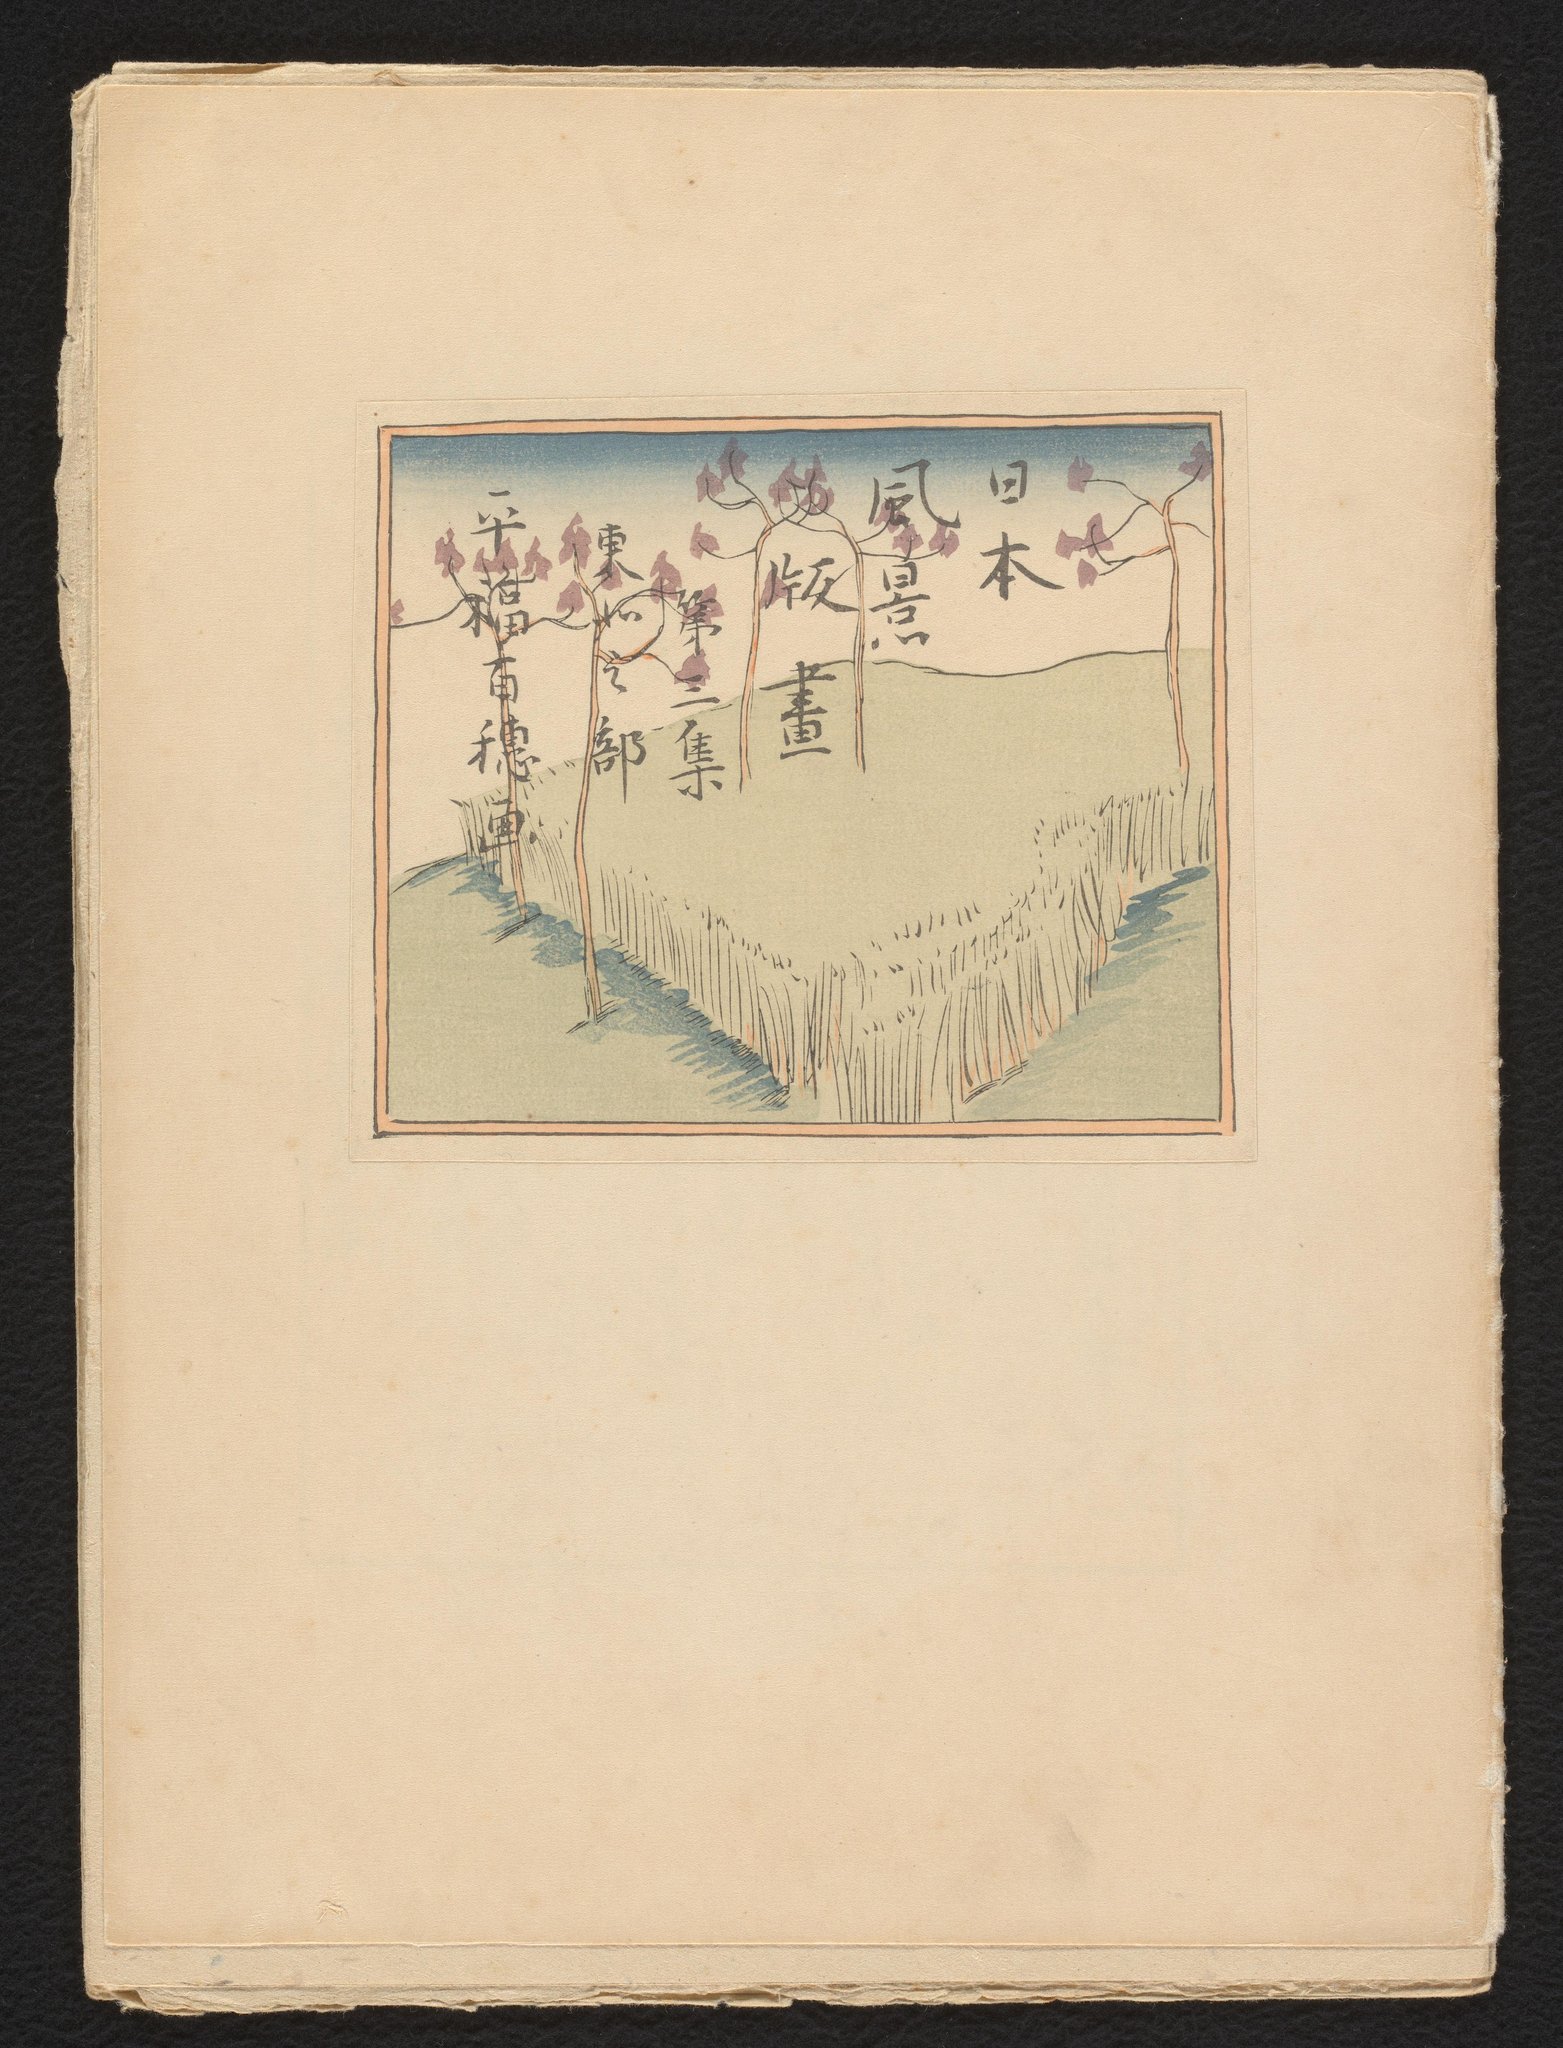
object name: prentrecueil, prentenalbum, prentalbum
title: Nihon fûkei hanga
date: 1917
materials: paper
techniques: woodcut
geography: japan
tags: tohoku-chiho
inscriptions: date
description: Originele omslag met titelblad waarop een weide met paarse bloesembomen is afgebeeld en een losse inhoudsopgave met colofon in het Japans met de titels van de 5 prenten met landschappen van Tôhoku, het noordelijke gedeelte van het grootste eiland van Japan, Honshû.